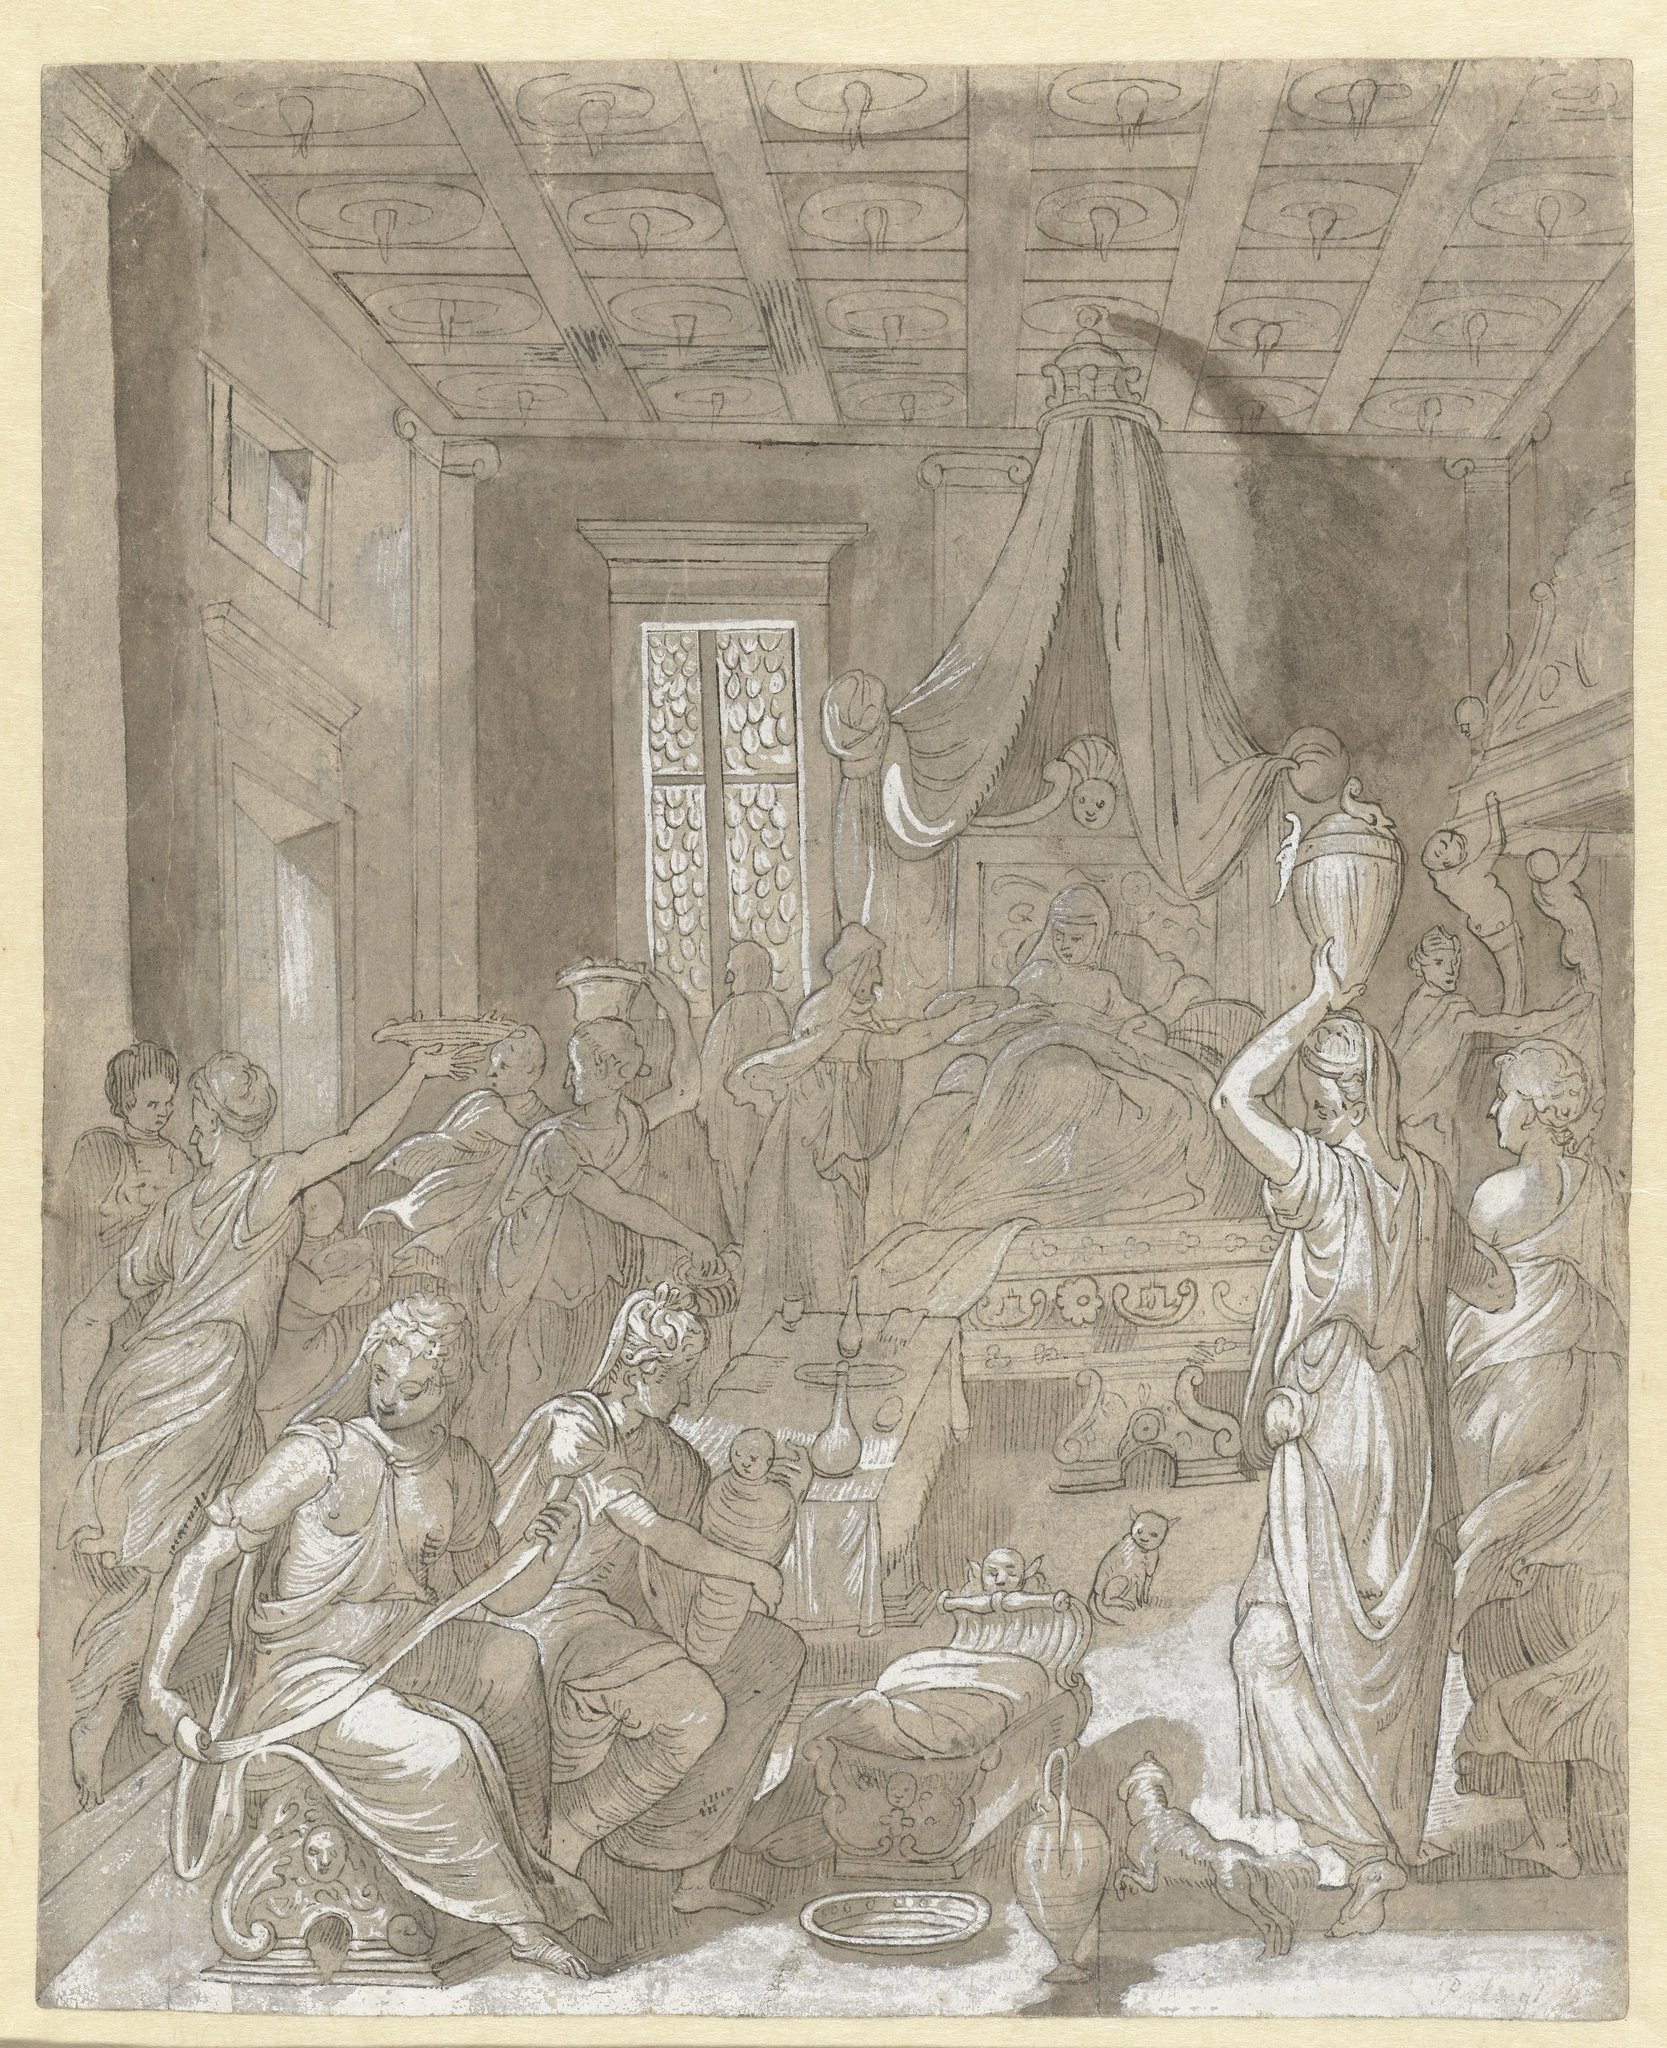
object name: drawing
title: Birth of the Virgin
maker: Anonymous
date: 1673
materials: paint, ink, paper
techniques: brush, pen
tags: interior of the house, several childbed scenes ~ birth of mary